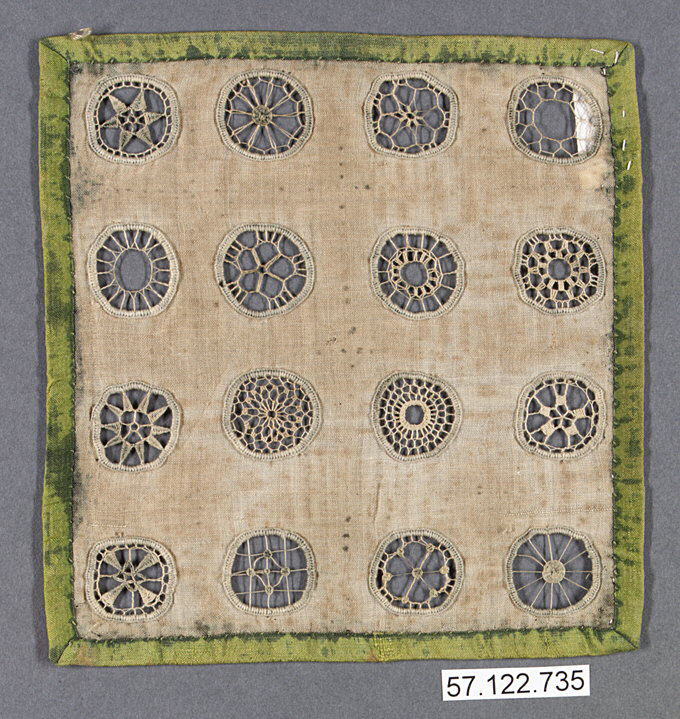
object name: sampler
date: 1801-1900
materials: linen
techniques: lace